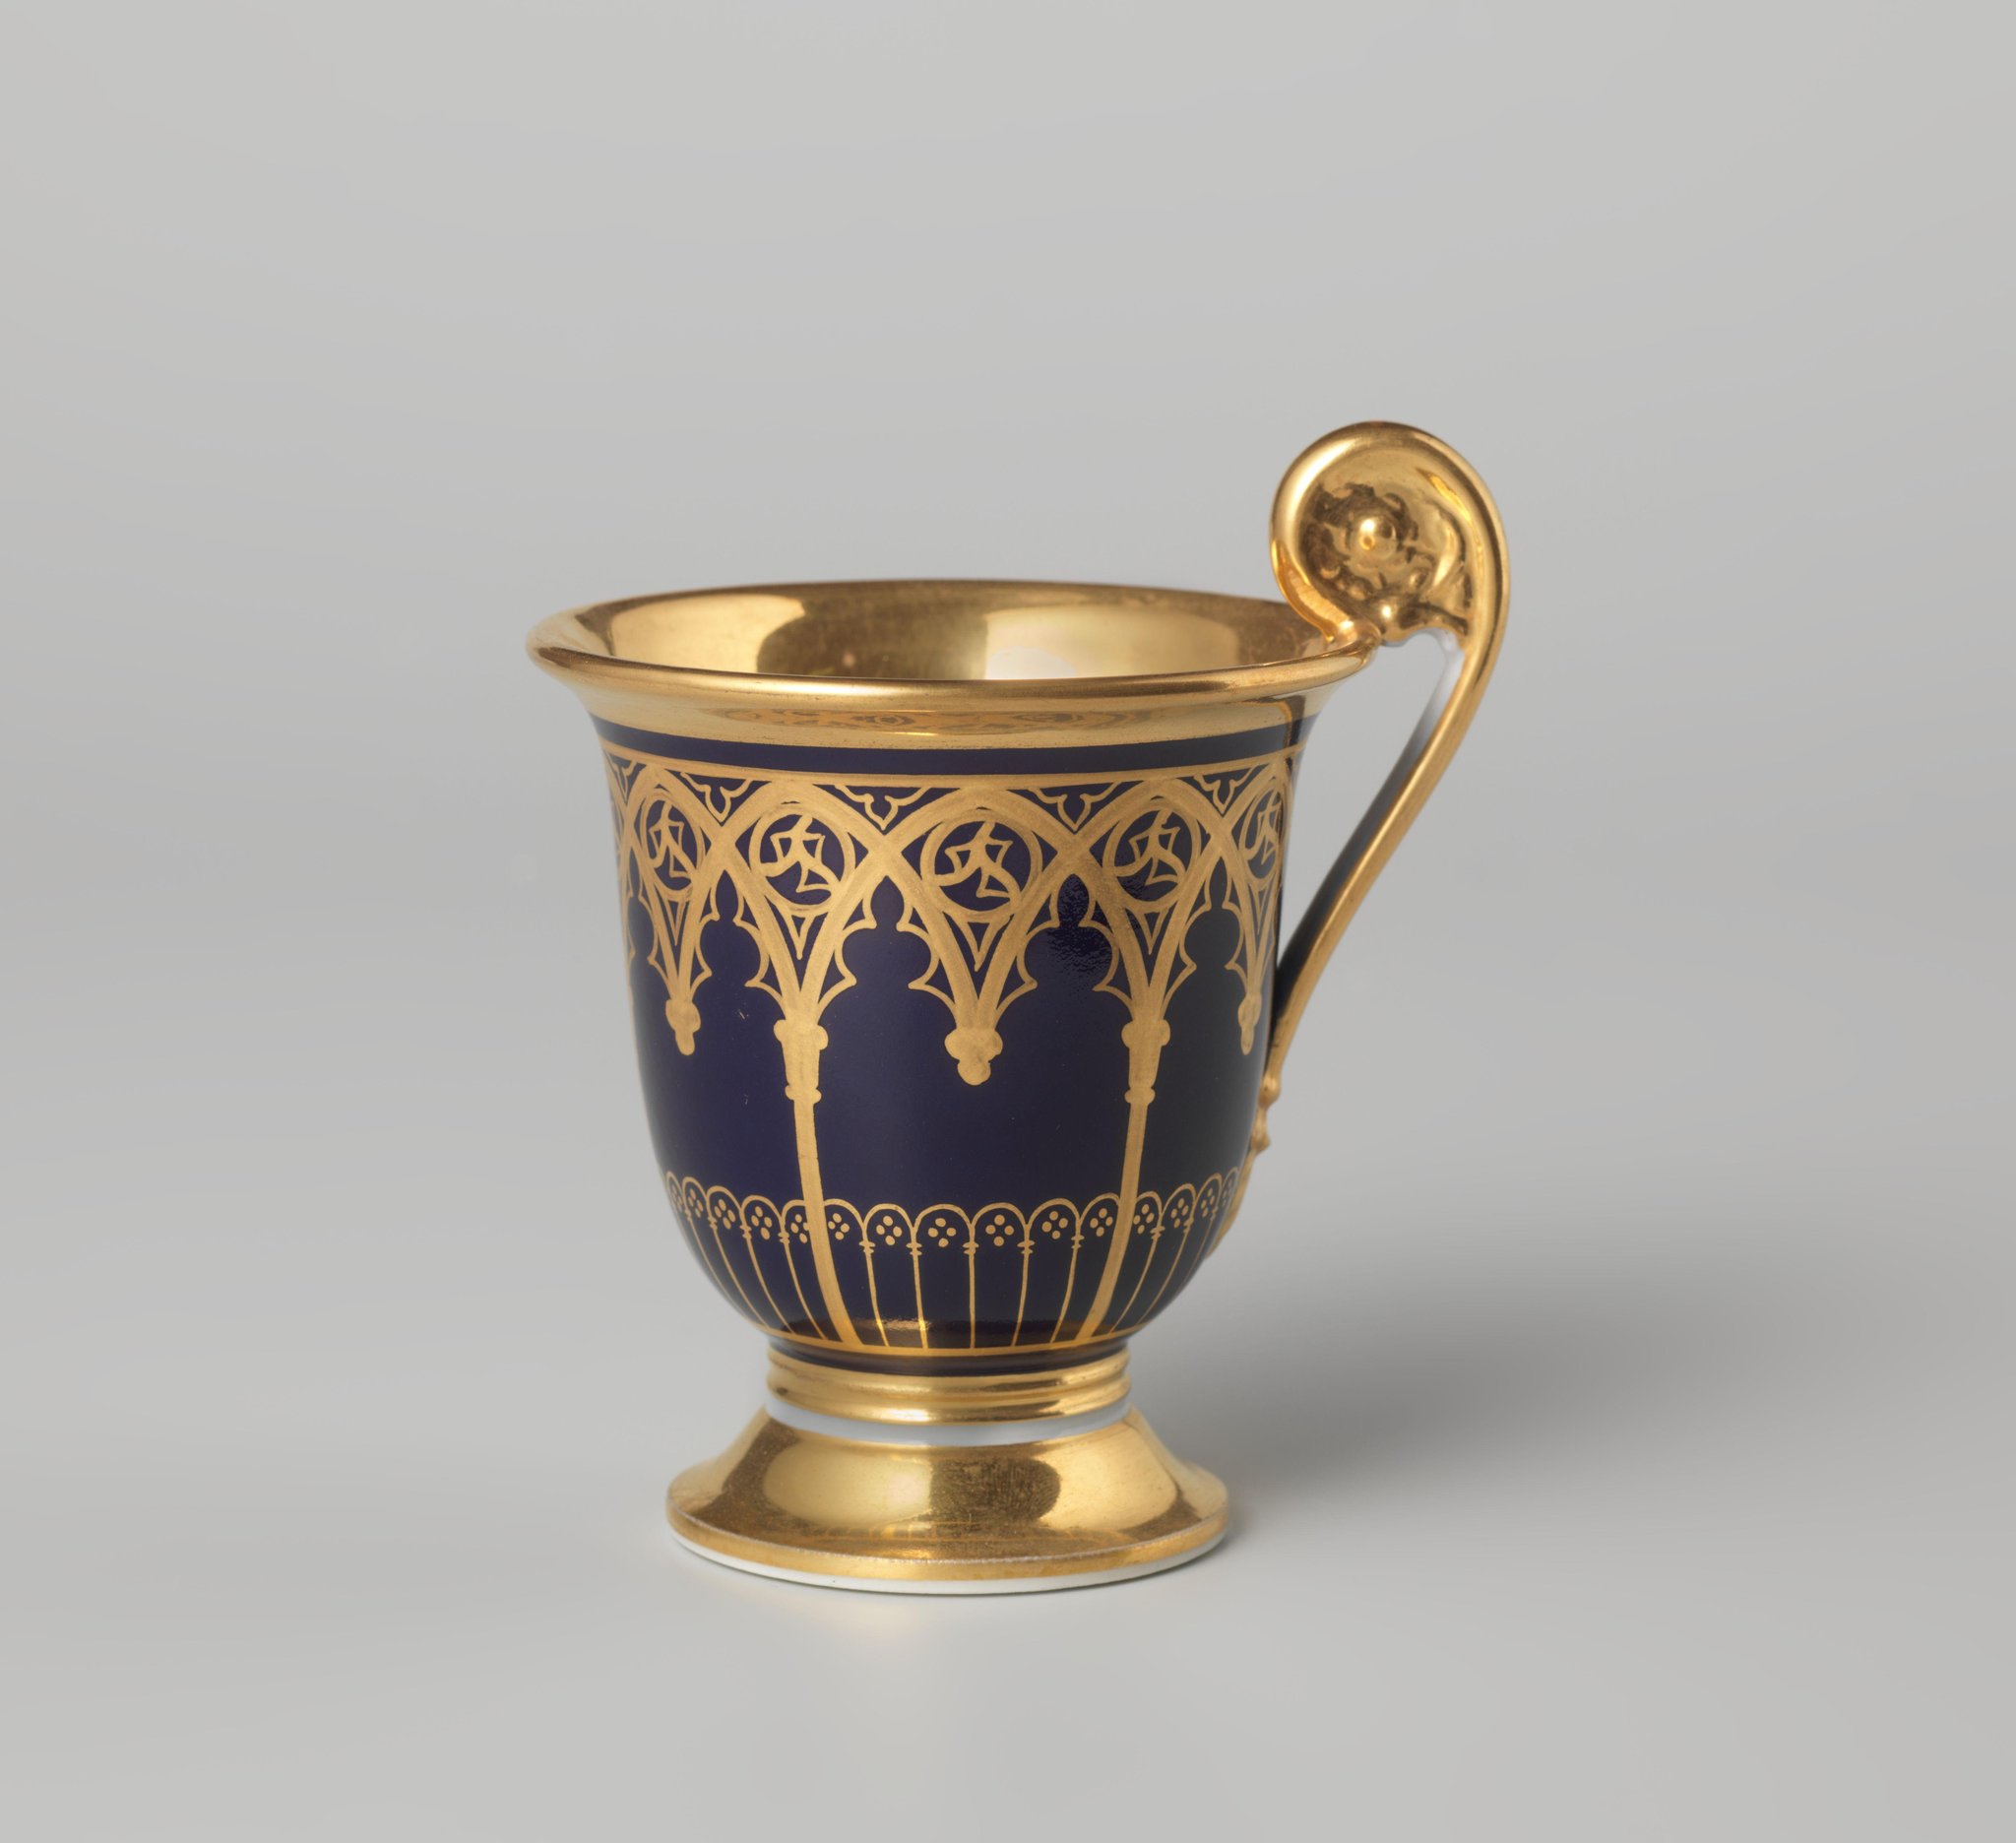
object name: cup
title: Cup with a gothic arcade decoration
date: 1800-1899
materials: cobalt, glaze, gold, paint, porcelain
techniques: firing, forming, gilding, turning, vitrification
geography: saint-yrieix-la-perche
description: Kop van porselein op spreidende voet en met een hoog, gekruld oor, beschilderd in onderglazuur blauw en op het glazuur goud. De buitenwand met een gotische boogdecoratie tegen een blauwe achtergrond. De voet, de rand, het oor en de helft van de binnenwand zijn bedekt met goud. In de krul van het oor een gemodelleerde rozet.